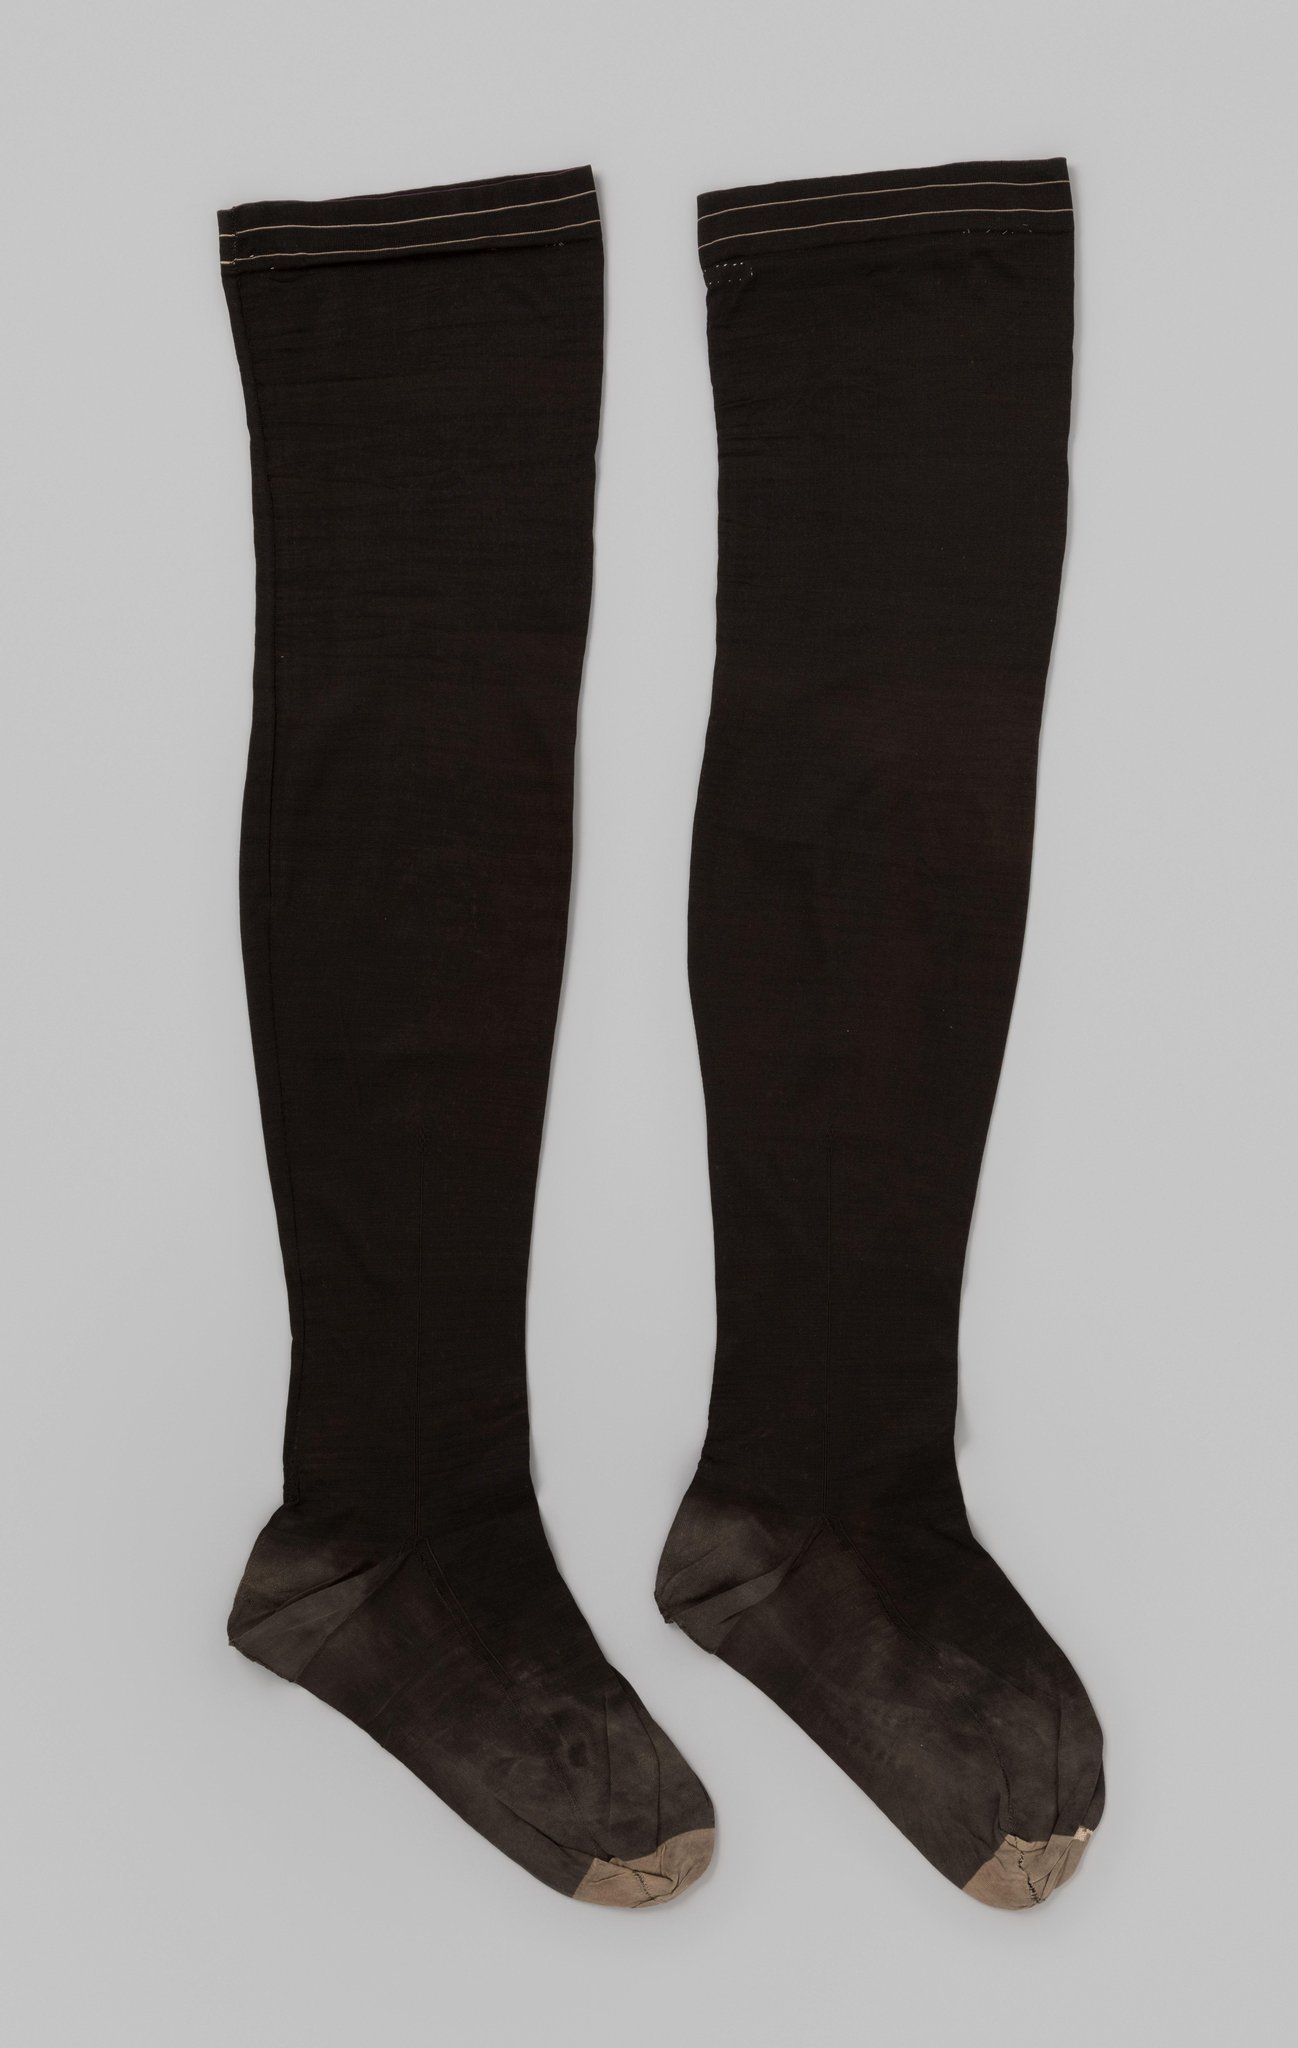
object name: court dress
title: Kous van zwarte zijde in tricot, bovenaan met twee witte strepen en één paarse streep en onderaan met beige teen en twee sierlijnen met bloem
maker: Anonymous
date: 1815-1830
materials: silk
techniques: embroidered, knitting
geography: paris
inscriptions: address: ‘'PARIS'’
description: In tricotsteek gebreide kous van zwarte zijde, bovenaan met twee witte strepen en één paarse streep en onderaan met beige teen en twee sierlijnen met bloem; gemerkt: Paris. Mogelijk hofkleding.